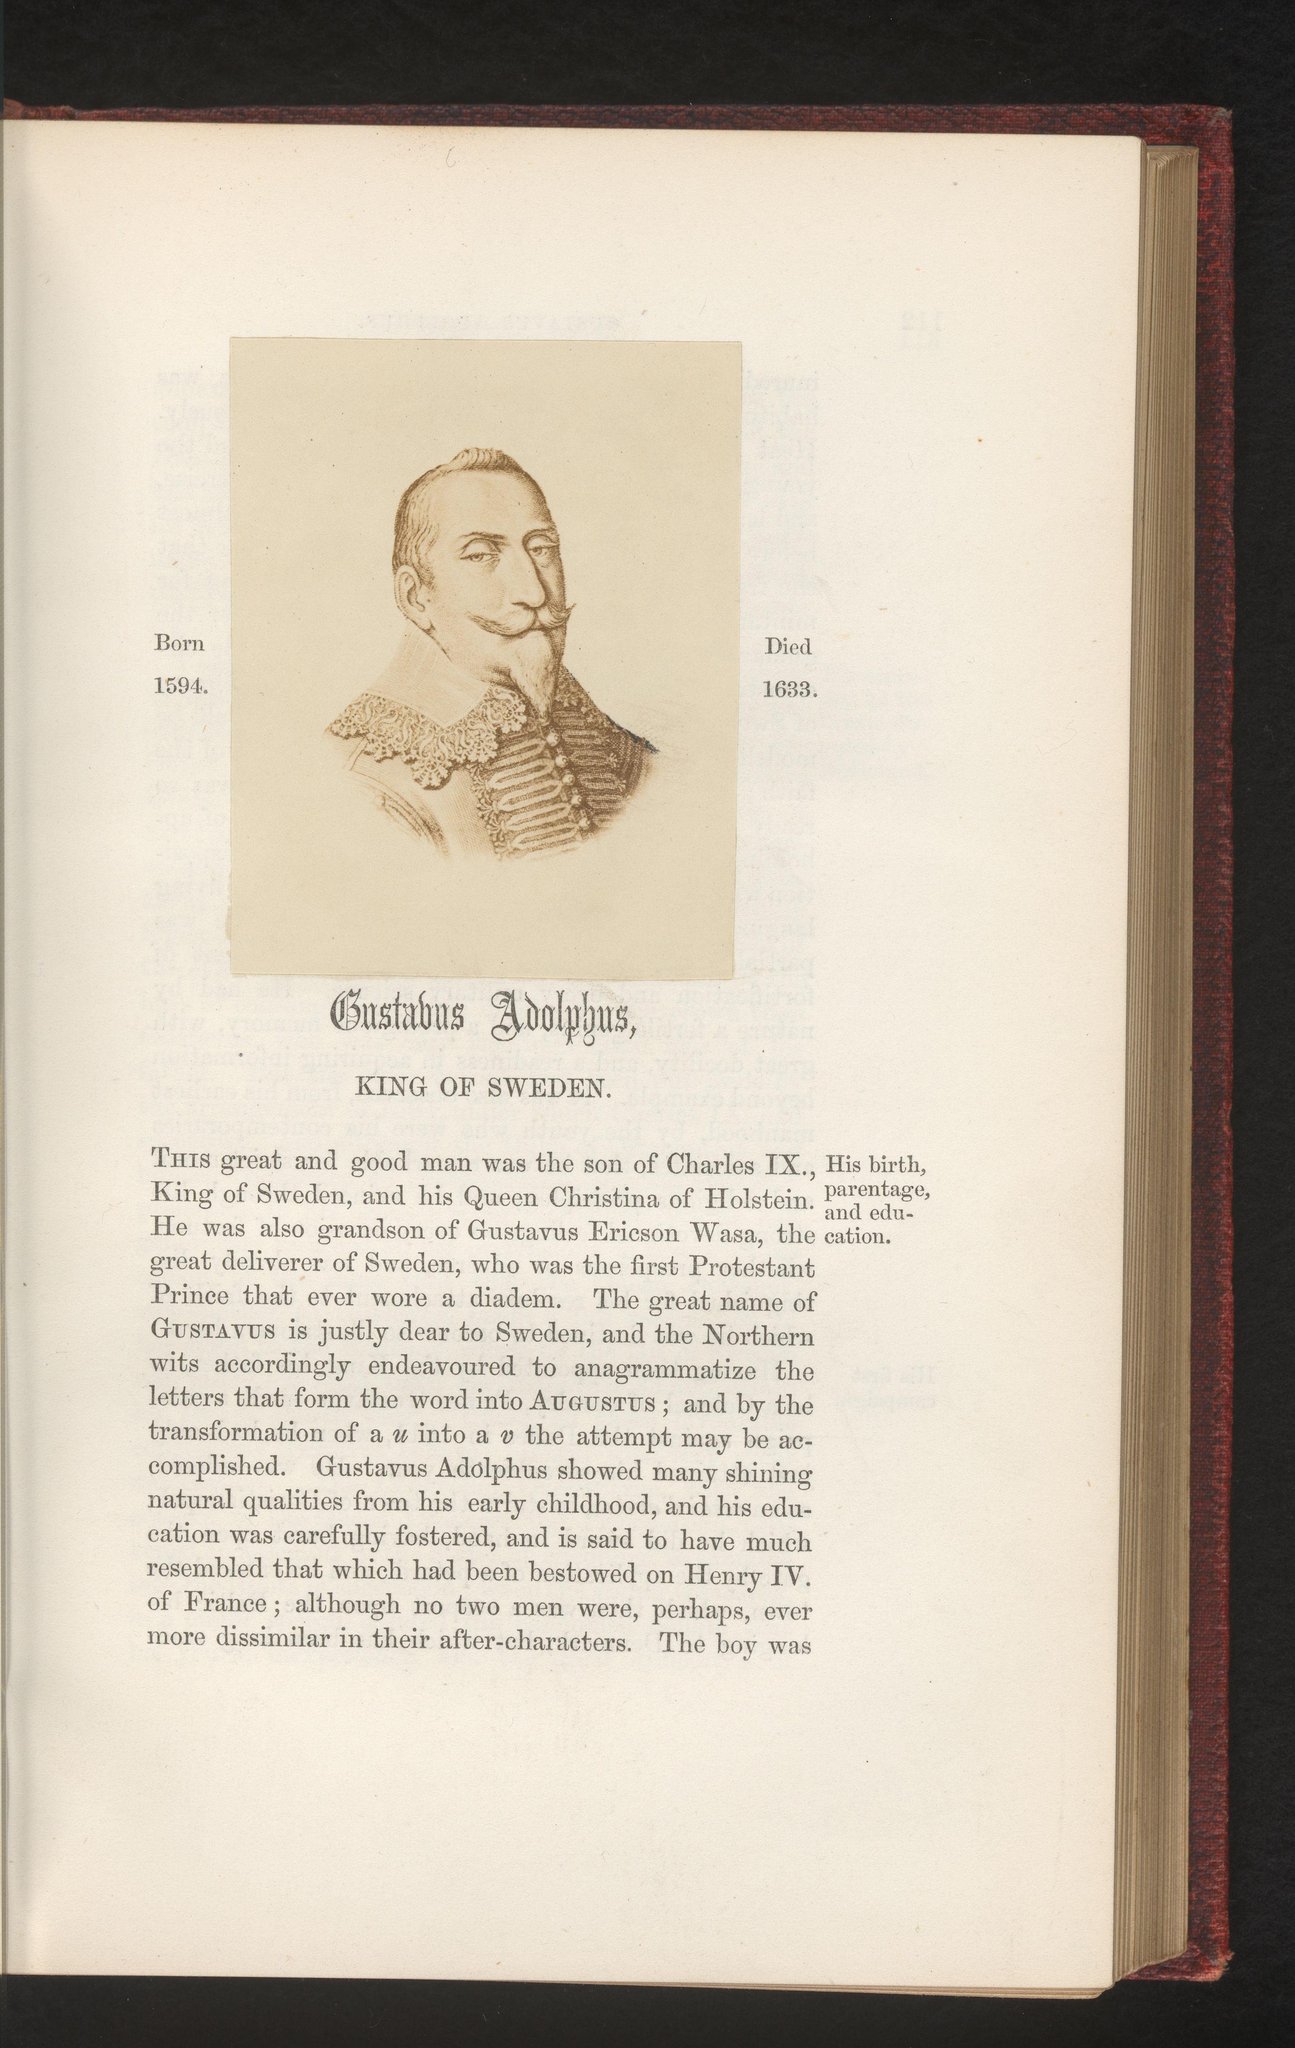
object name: page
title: Fotoreproductie van een portret van Gustaaf II Adolf (koning van Zweden)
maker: Anonymous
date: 1860-1865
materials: photographic support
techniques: albumen print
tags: historical persons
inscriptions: inscription: ‘Born 1594/ Died 1633/ King of Sweden’